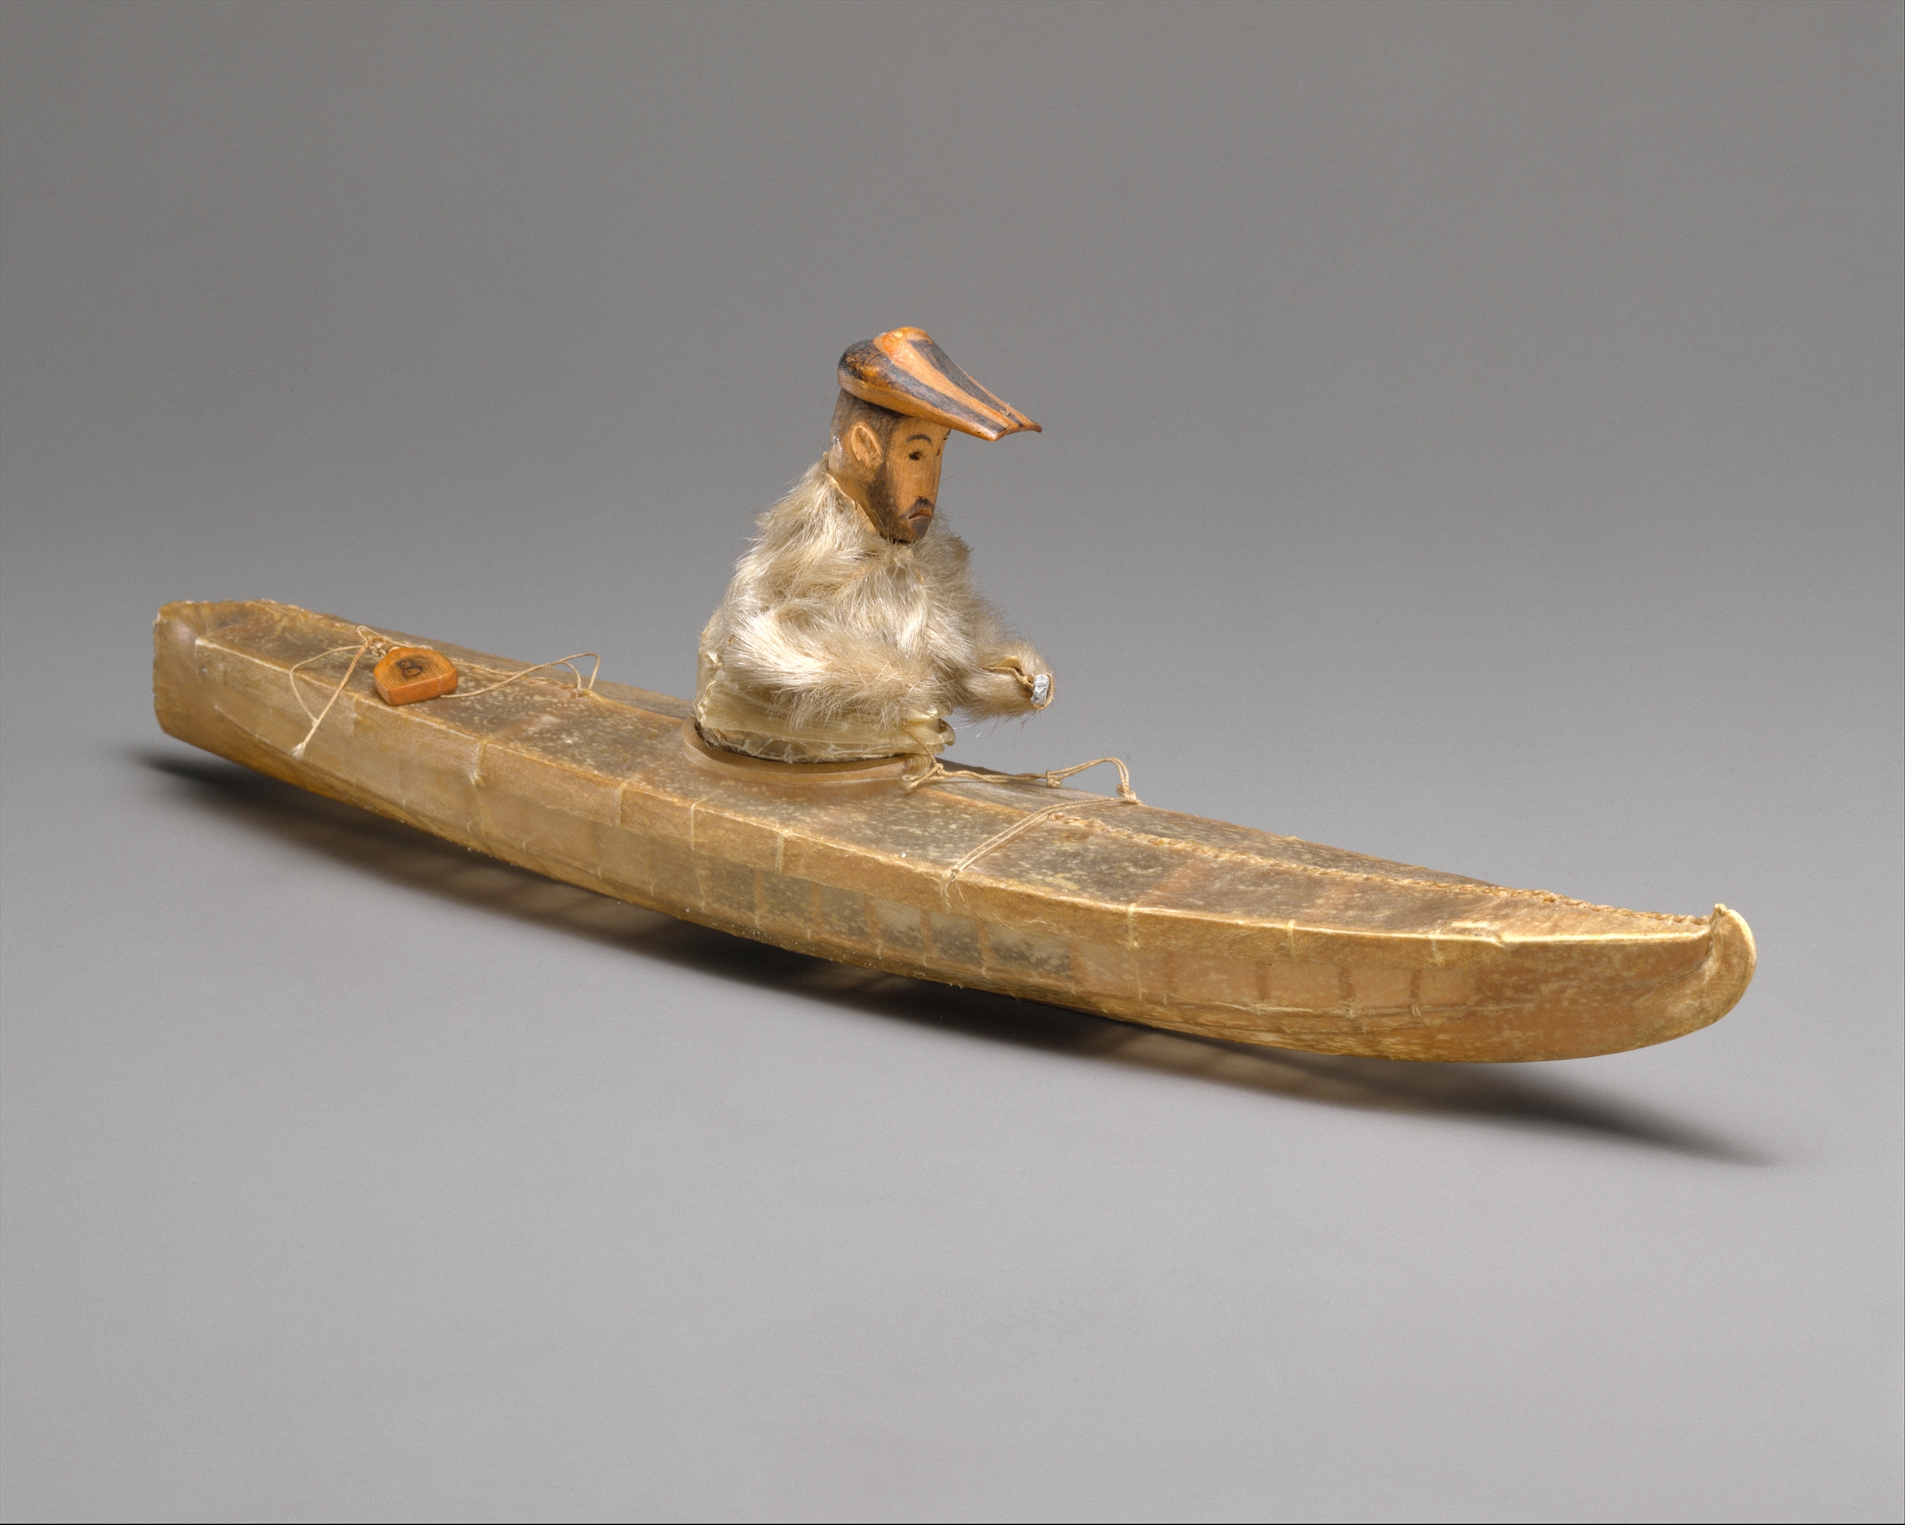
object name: kayak model with hunter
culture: aleut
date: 1840-1850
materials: fur, pigment, wood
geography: united states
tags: men,boats